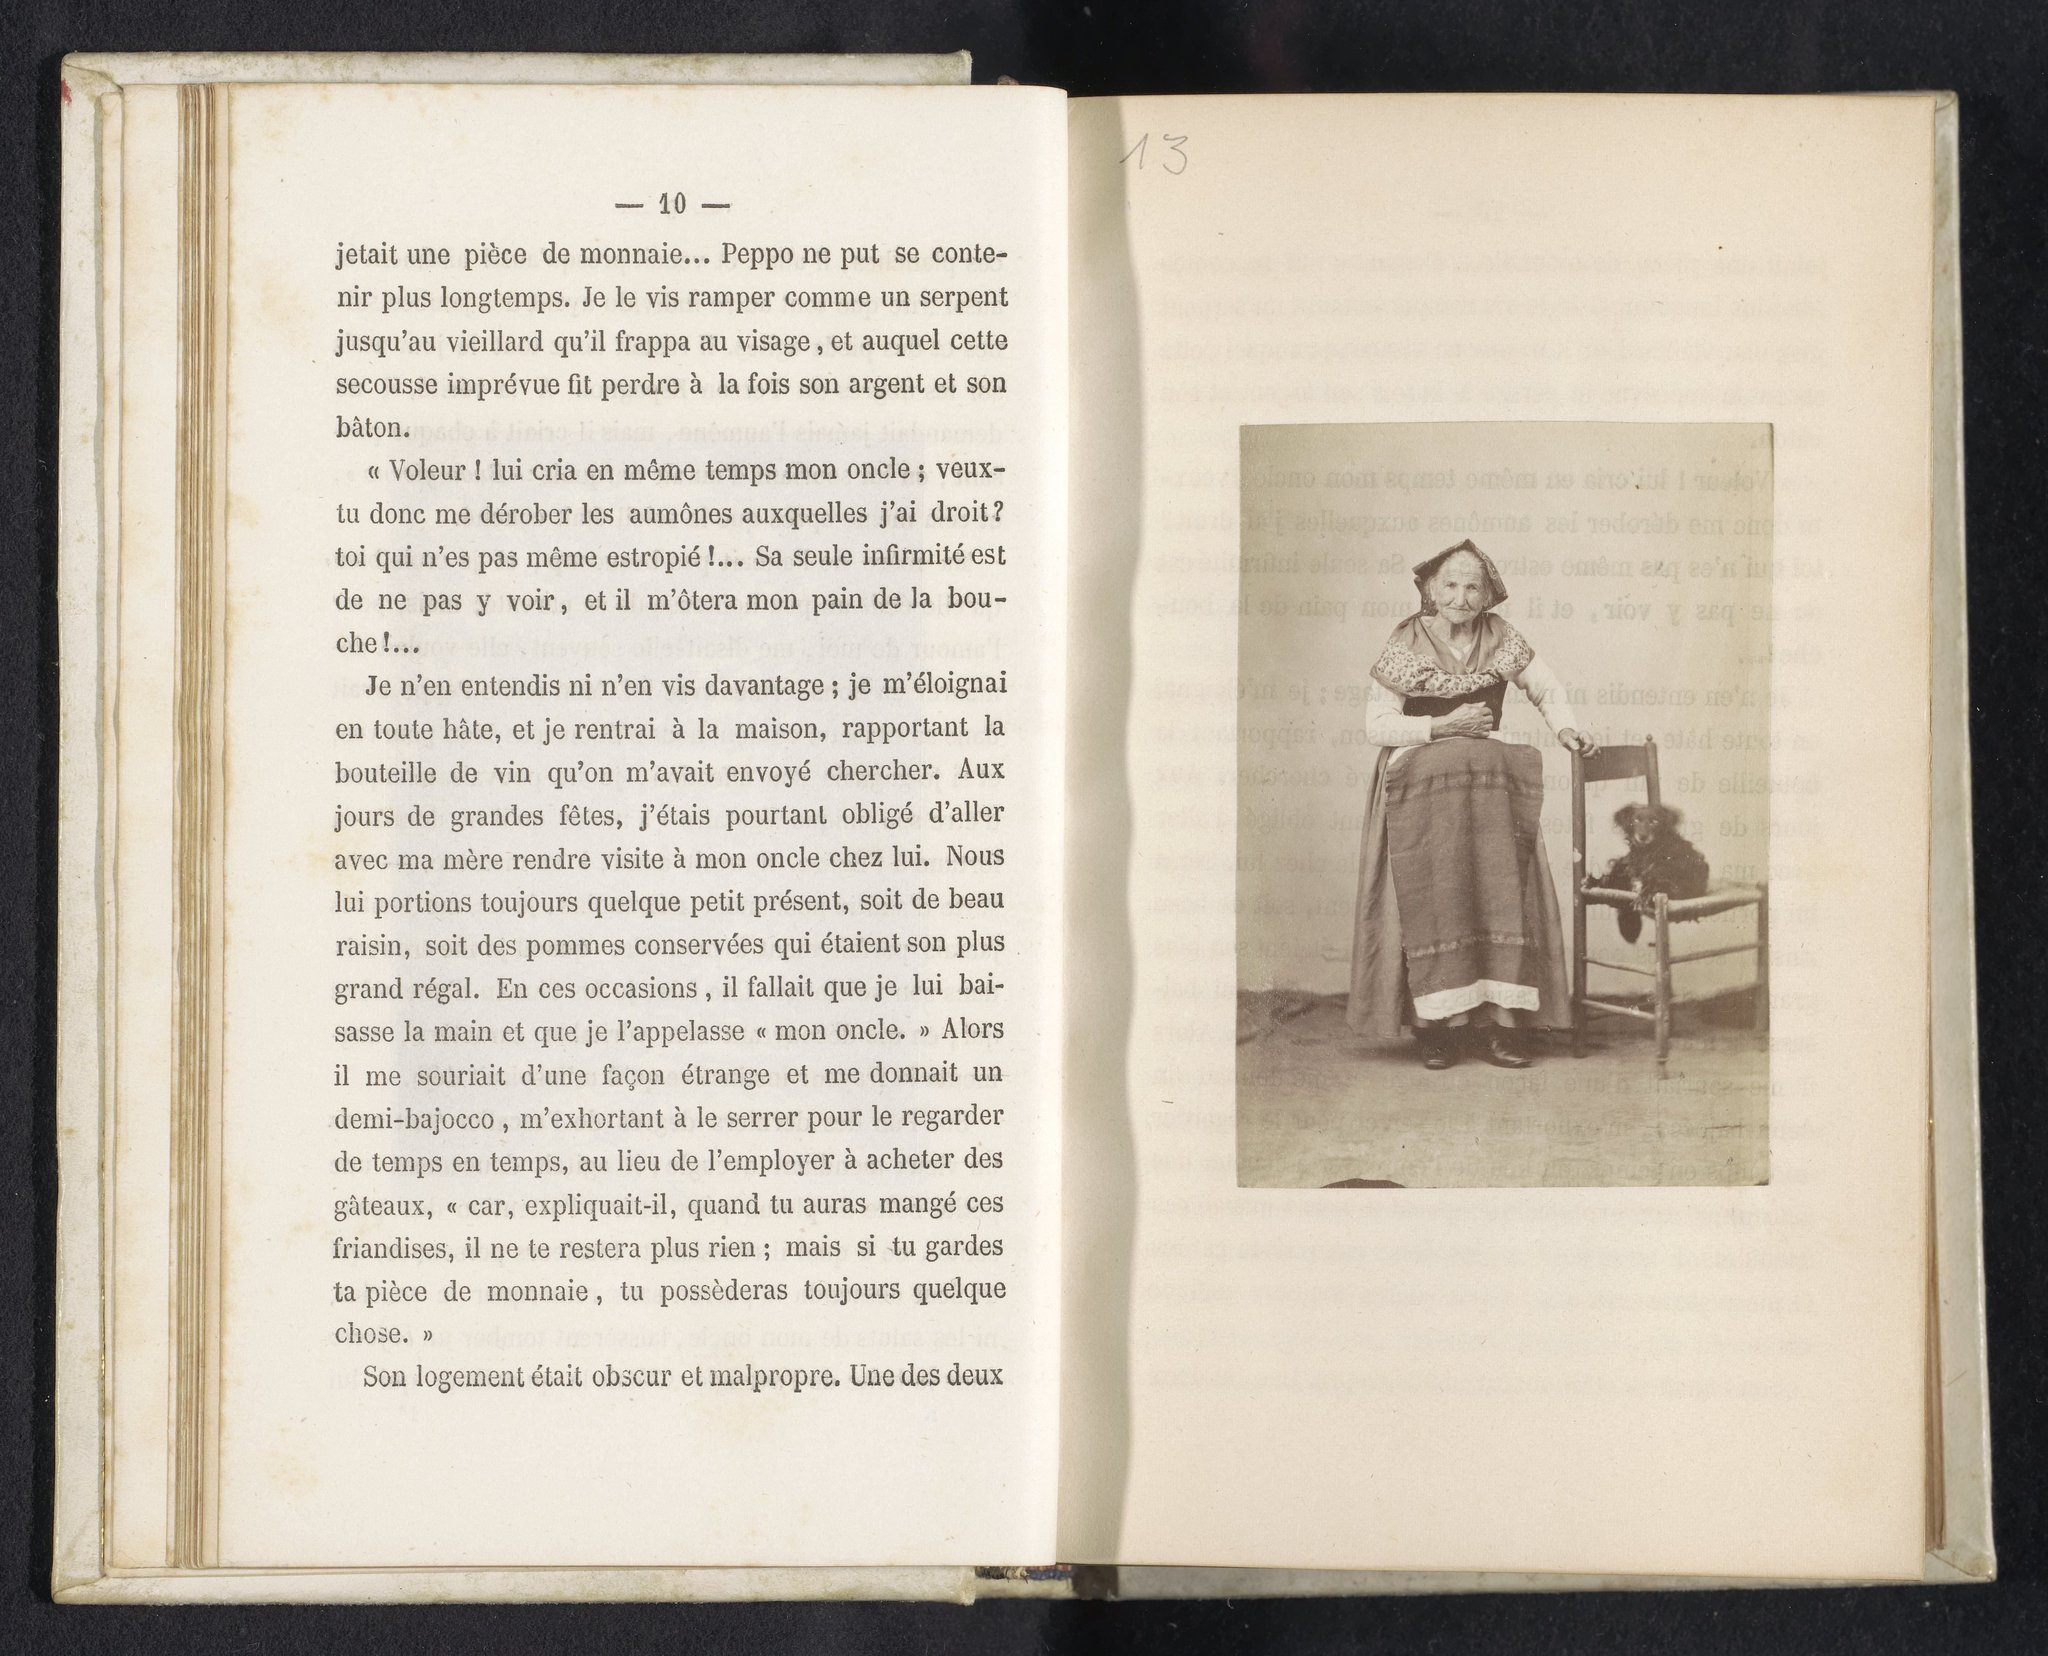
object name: photograph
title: Portret van een onbekende oude vrouw en een hond op een stoel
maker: Anonymous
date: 1850-1860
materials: photographic support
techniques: albumen print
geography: italy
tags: historical persons not known by name - bb - woman, old woman, dog